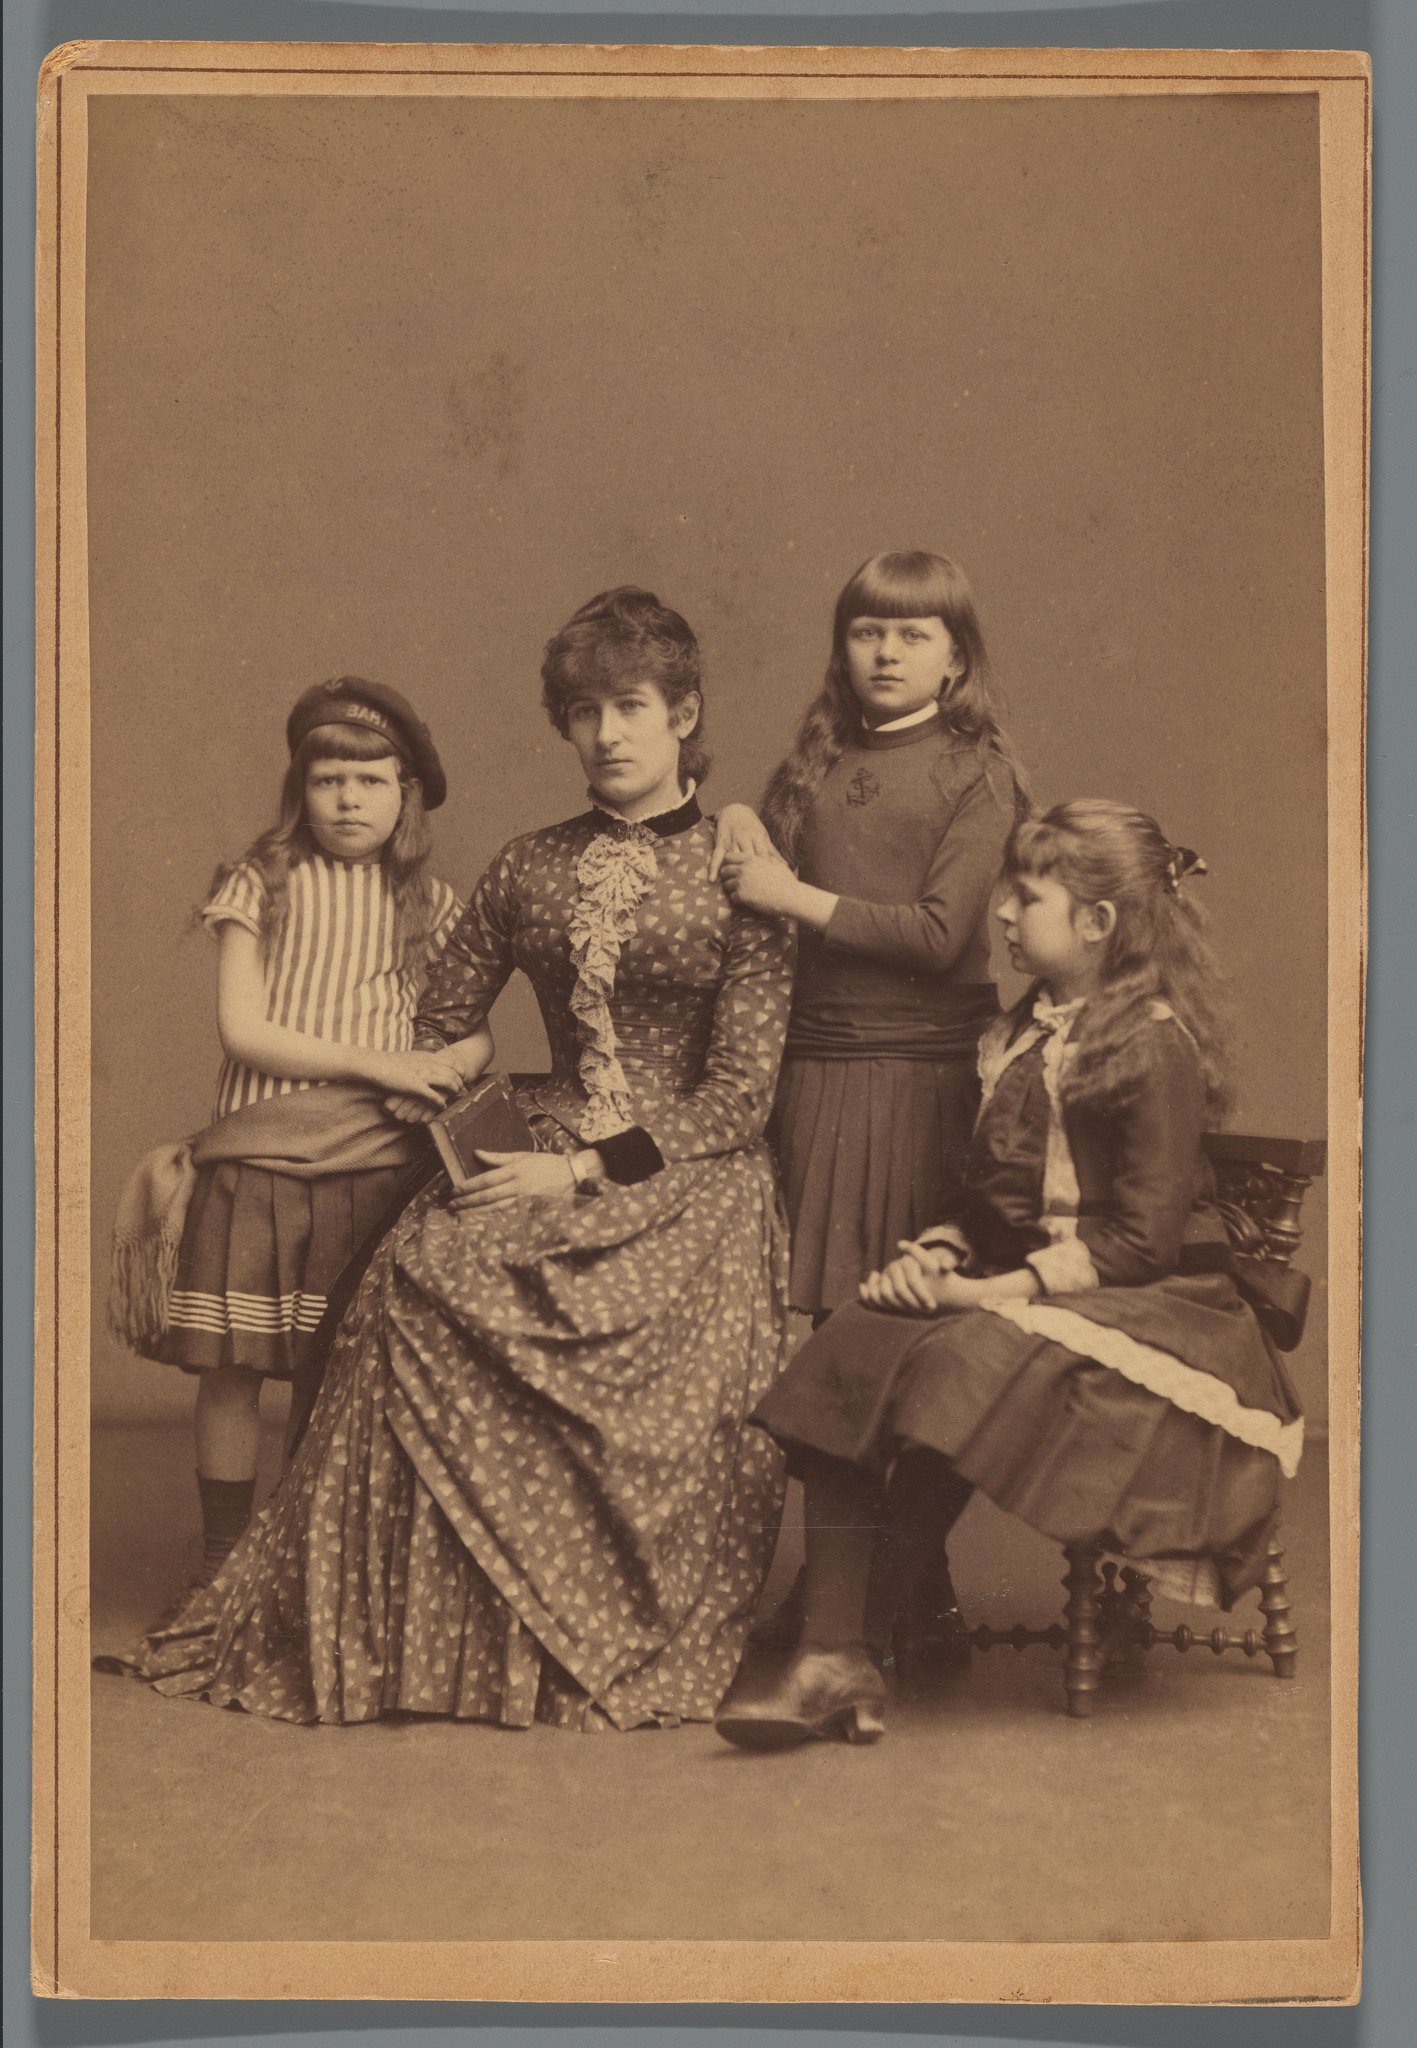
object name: cabinet photograph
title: Studioportret van Francine Schas met drie dochters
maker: johan christiaan reesinck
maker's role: fotograaf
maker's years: 1838-1922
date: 1885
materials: cardboard, photographic support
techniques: albumen print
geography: zutphen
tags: francina schas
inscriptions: name, name: ‘tante Dèlle Wichers-Dupuis / met De, ...’